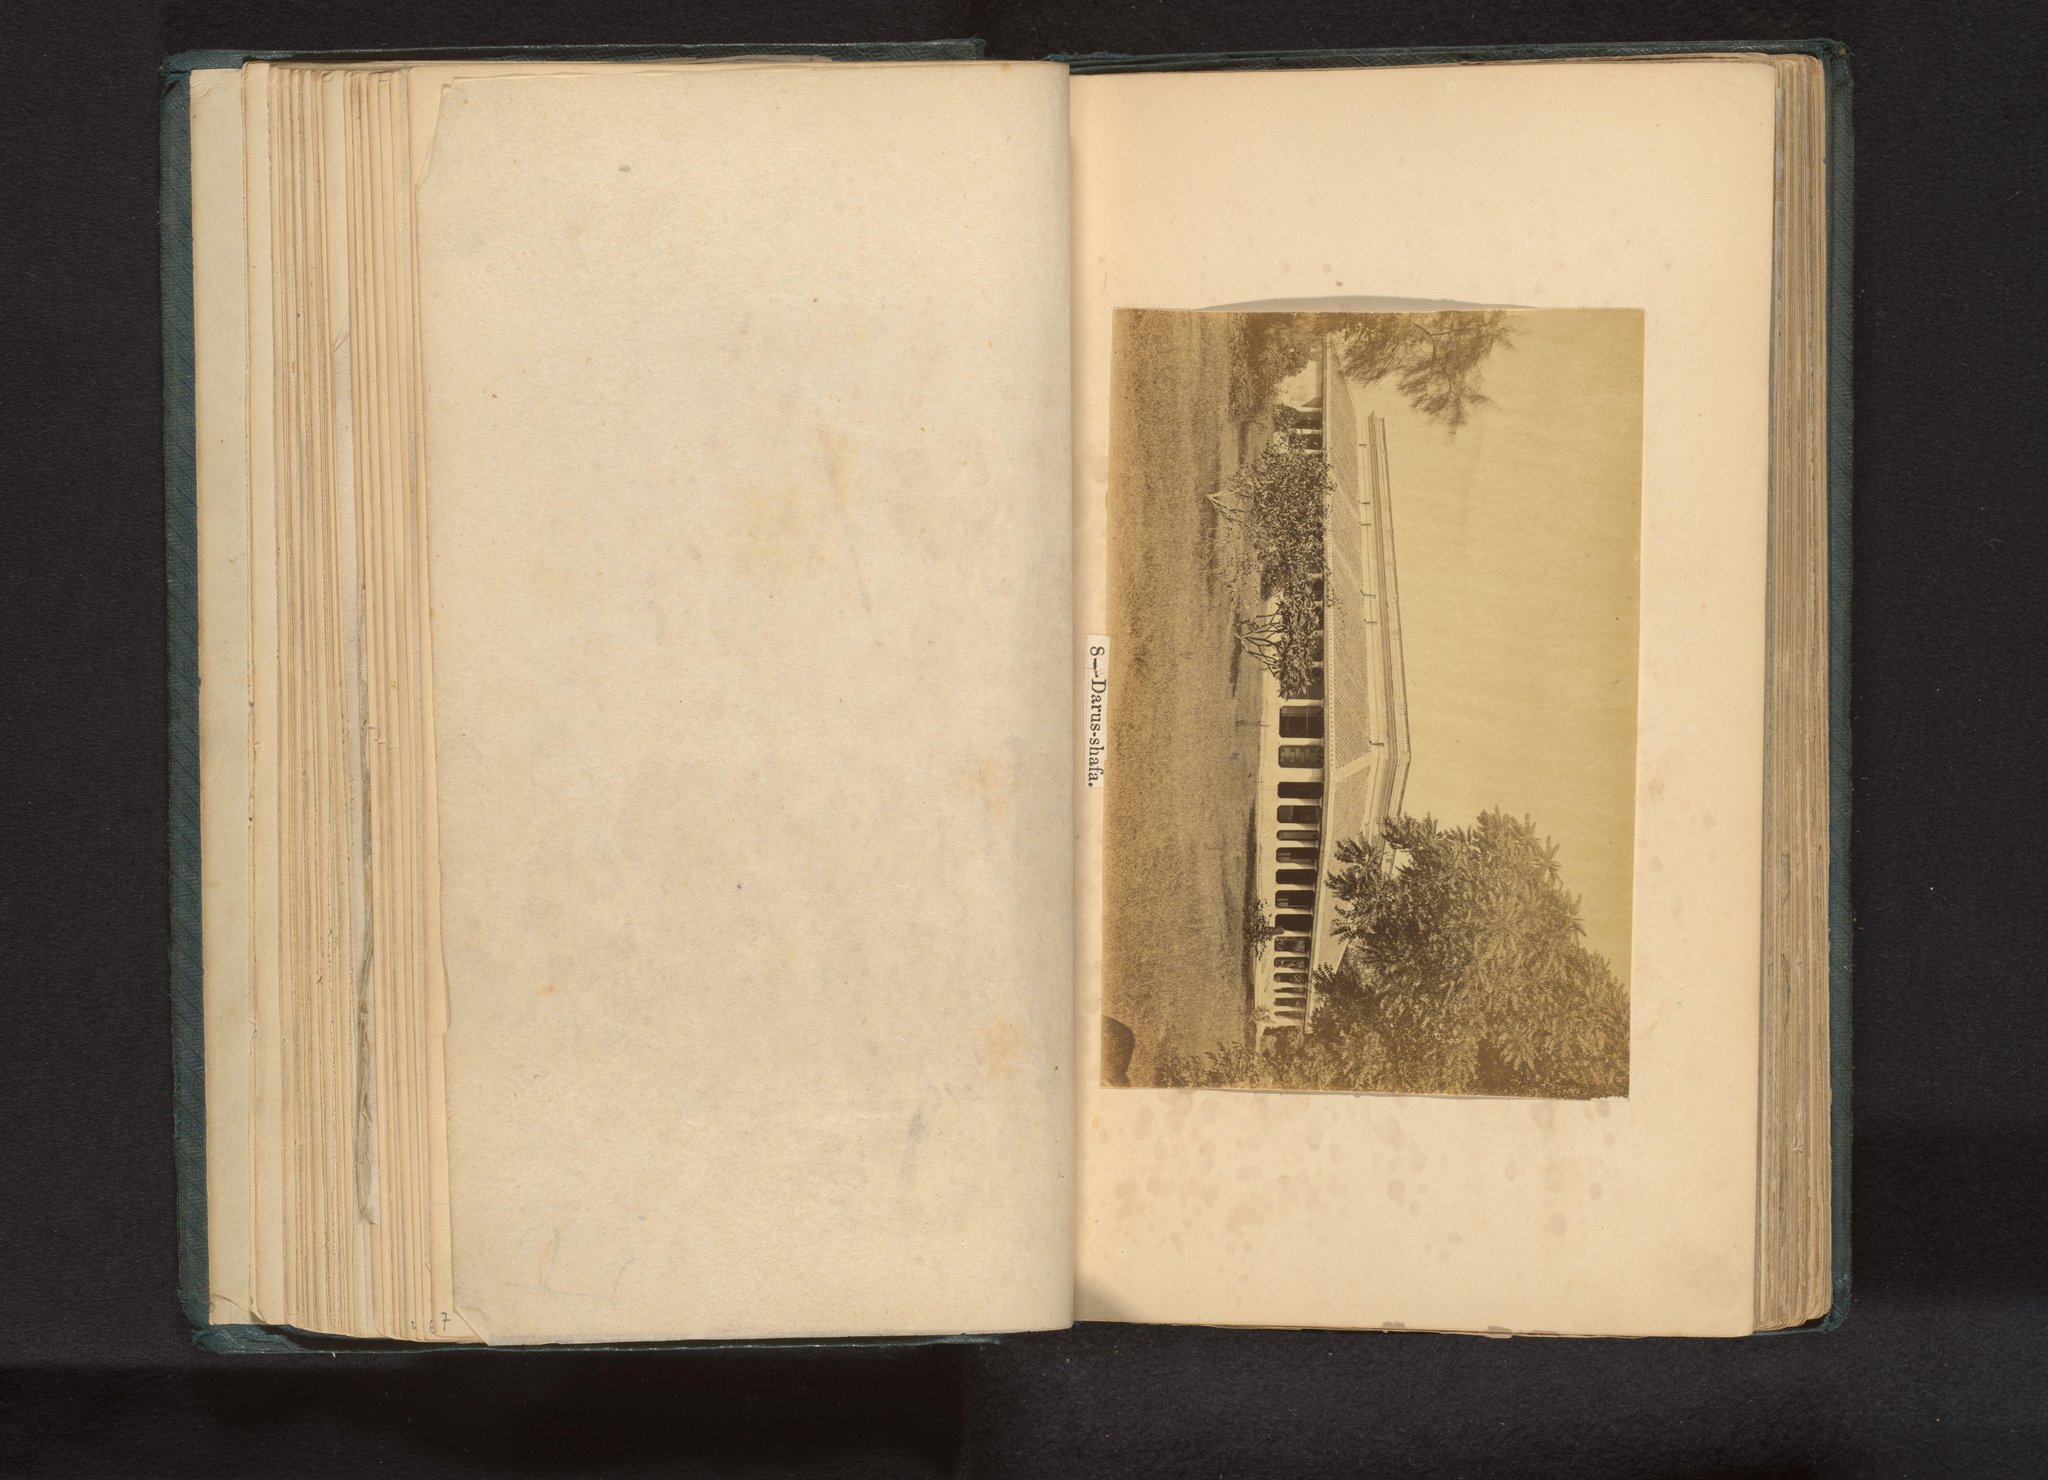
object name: page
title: Darus-shafa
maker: darogha ubbas alli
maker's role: fotograaf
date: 1864-1874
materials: photographic support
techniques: albumen print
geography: lucknow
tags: hospital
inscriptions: number: ‘8’